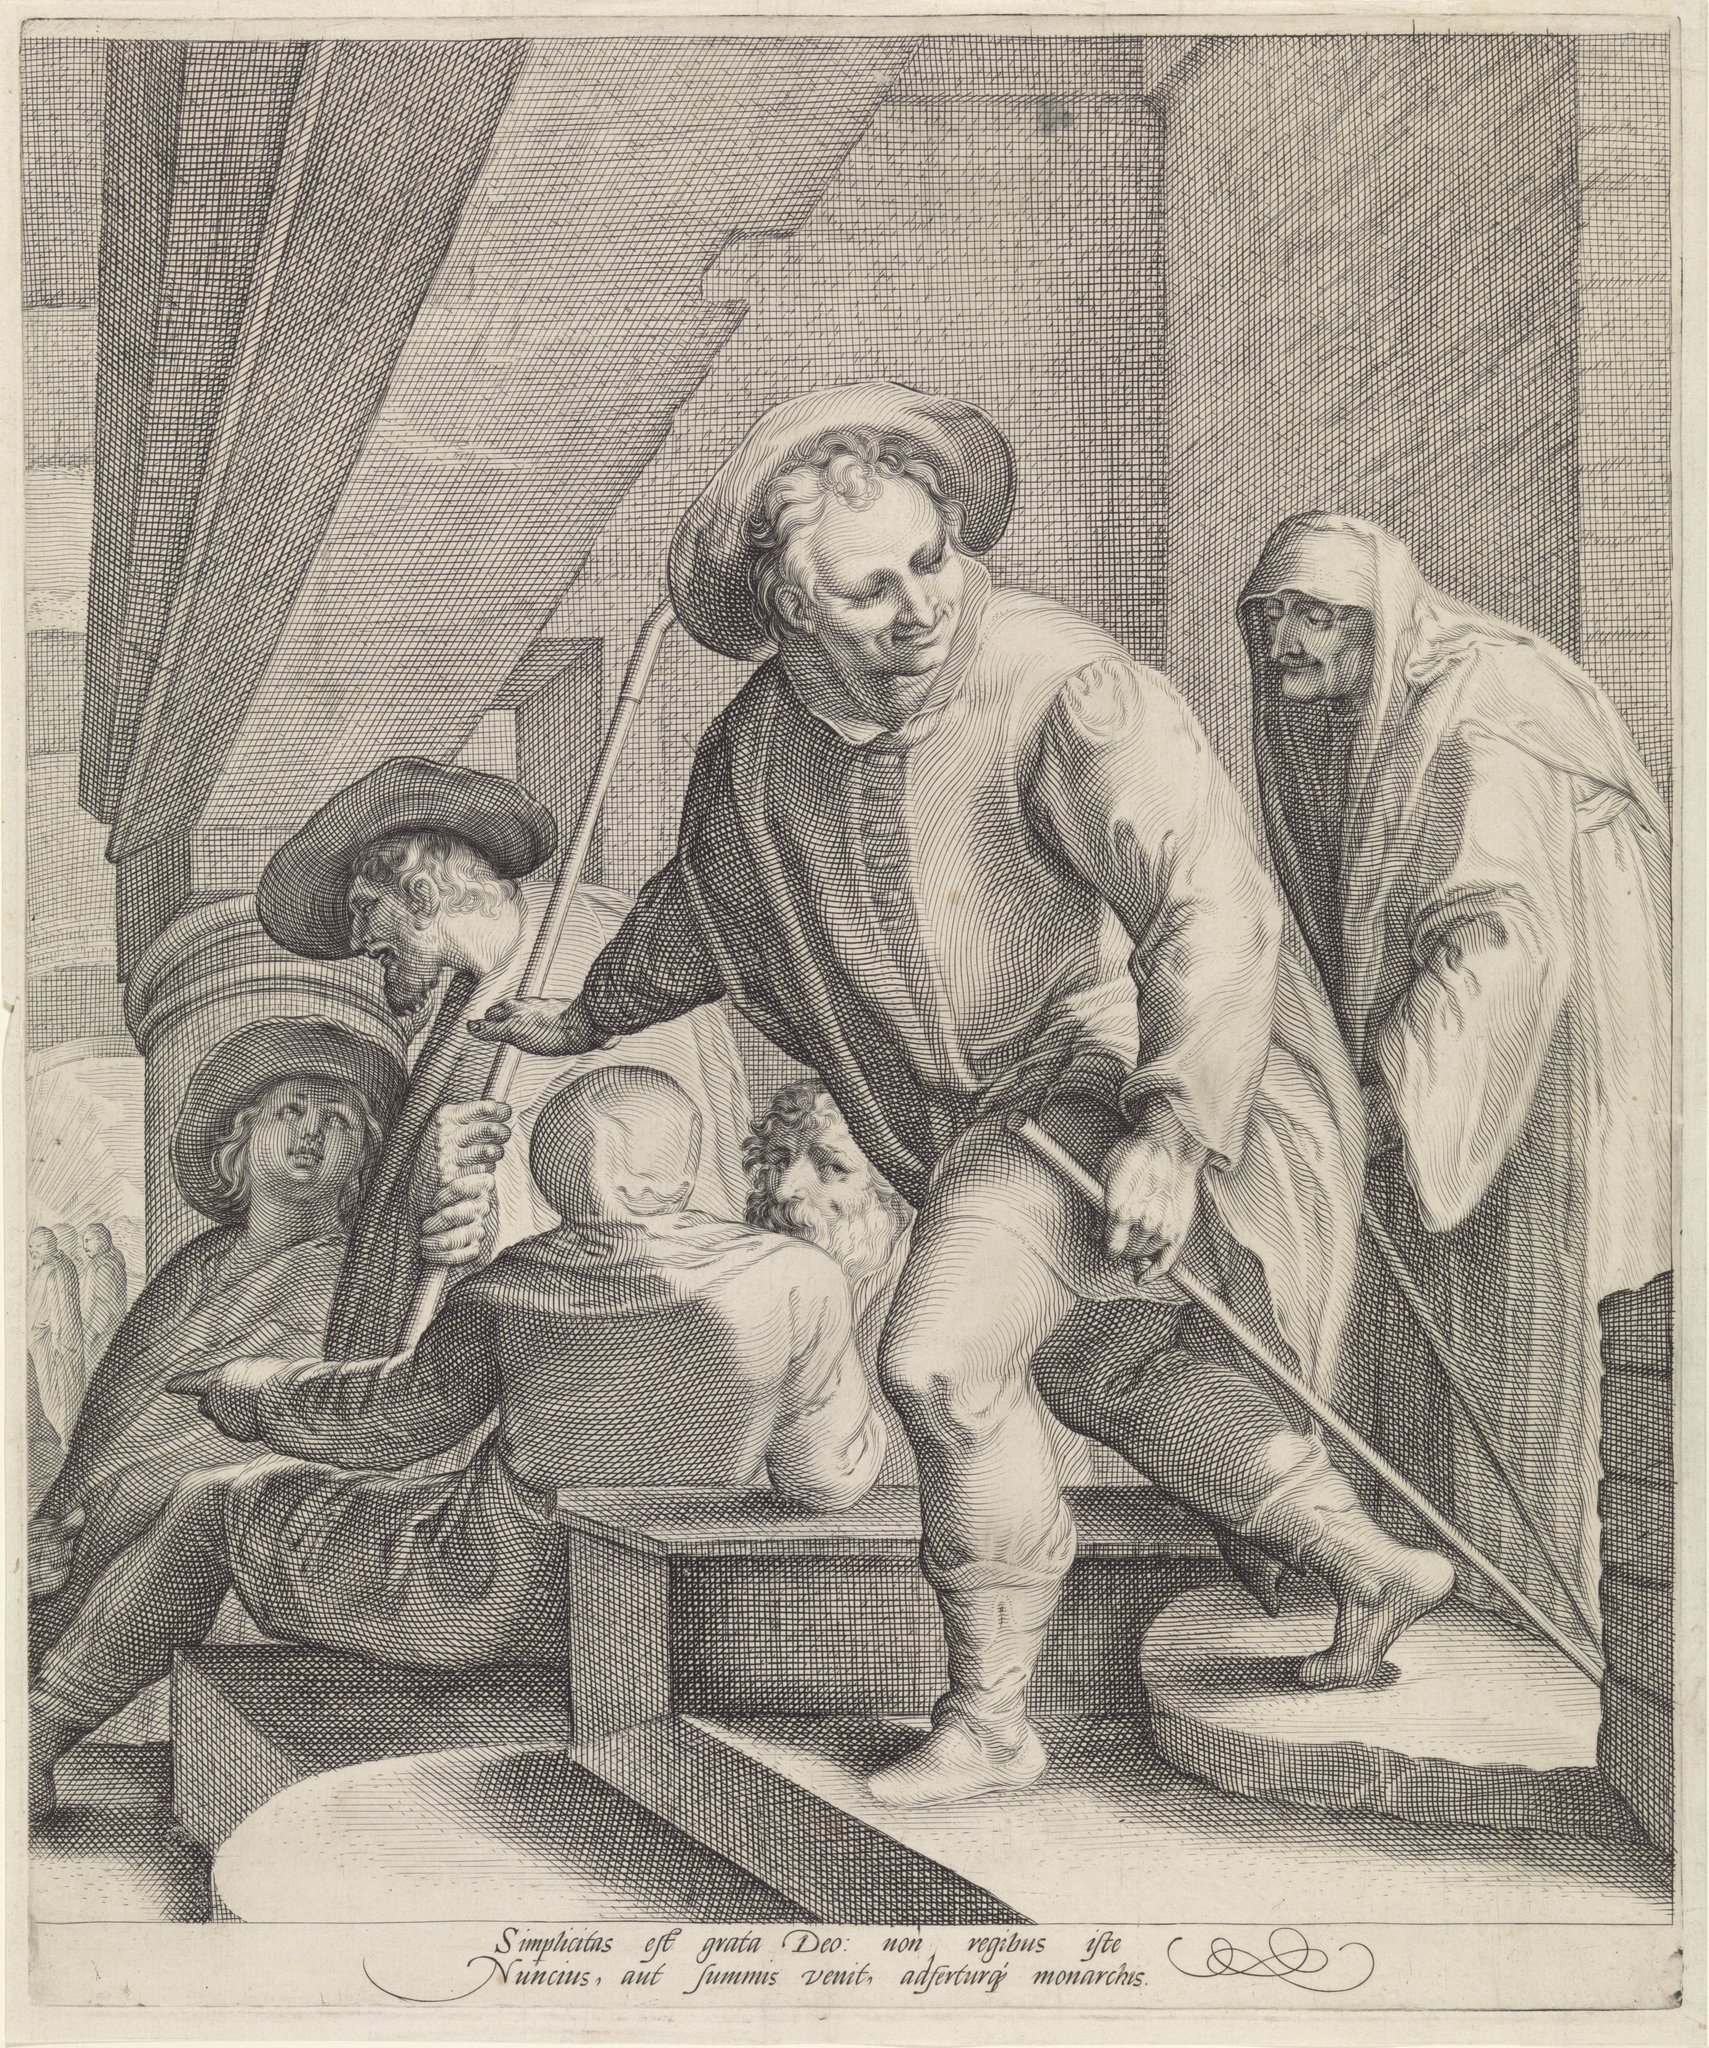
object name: print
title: Aanbidding door de herders (rechter blad)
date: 1601-1652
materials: paper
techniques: engraving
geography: amsterdam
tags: adoration of the christ-child by the shepherds; mary and joseph present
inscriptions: collector's mark: Lugt 240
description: Enkele herders zitten en staan in een gewelfde ruimte. Rechts staat een oude vrouw. Onder de voorstelling een tweeregelige, Latijnse tekst met een toelichting op de aanbiddingsscène.